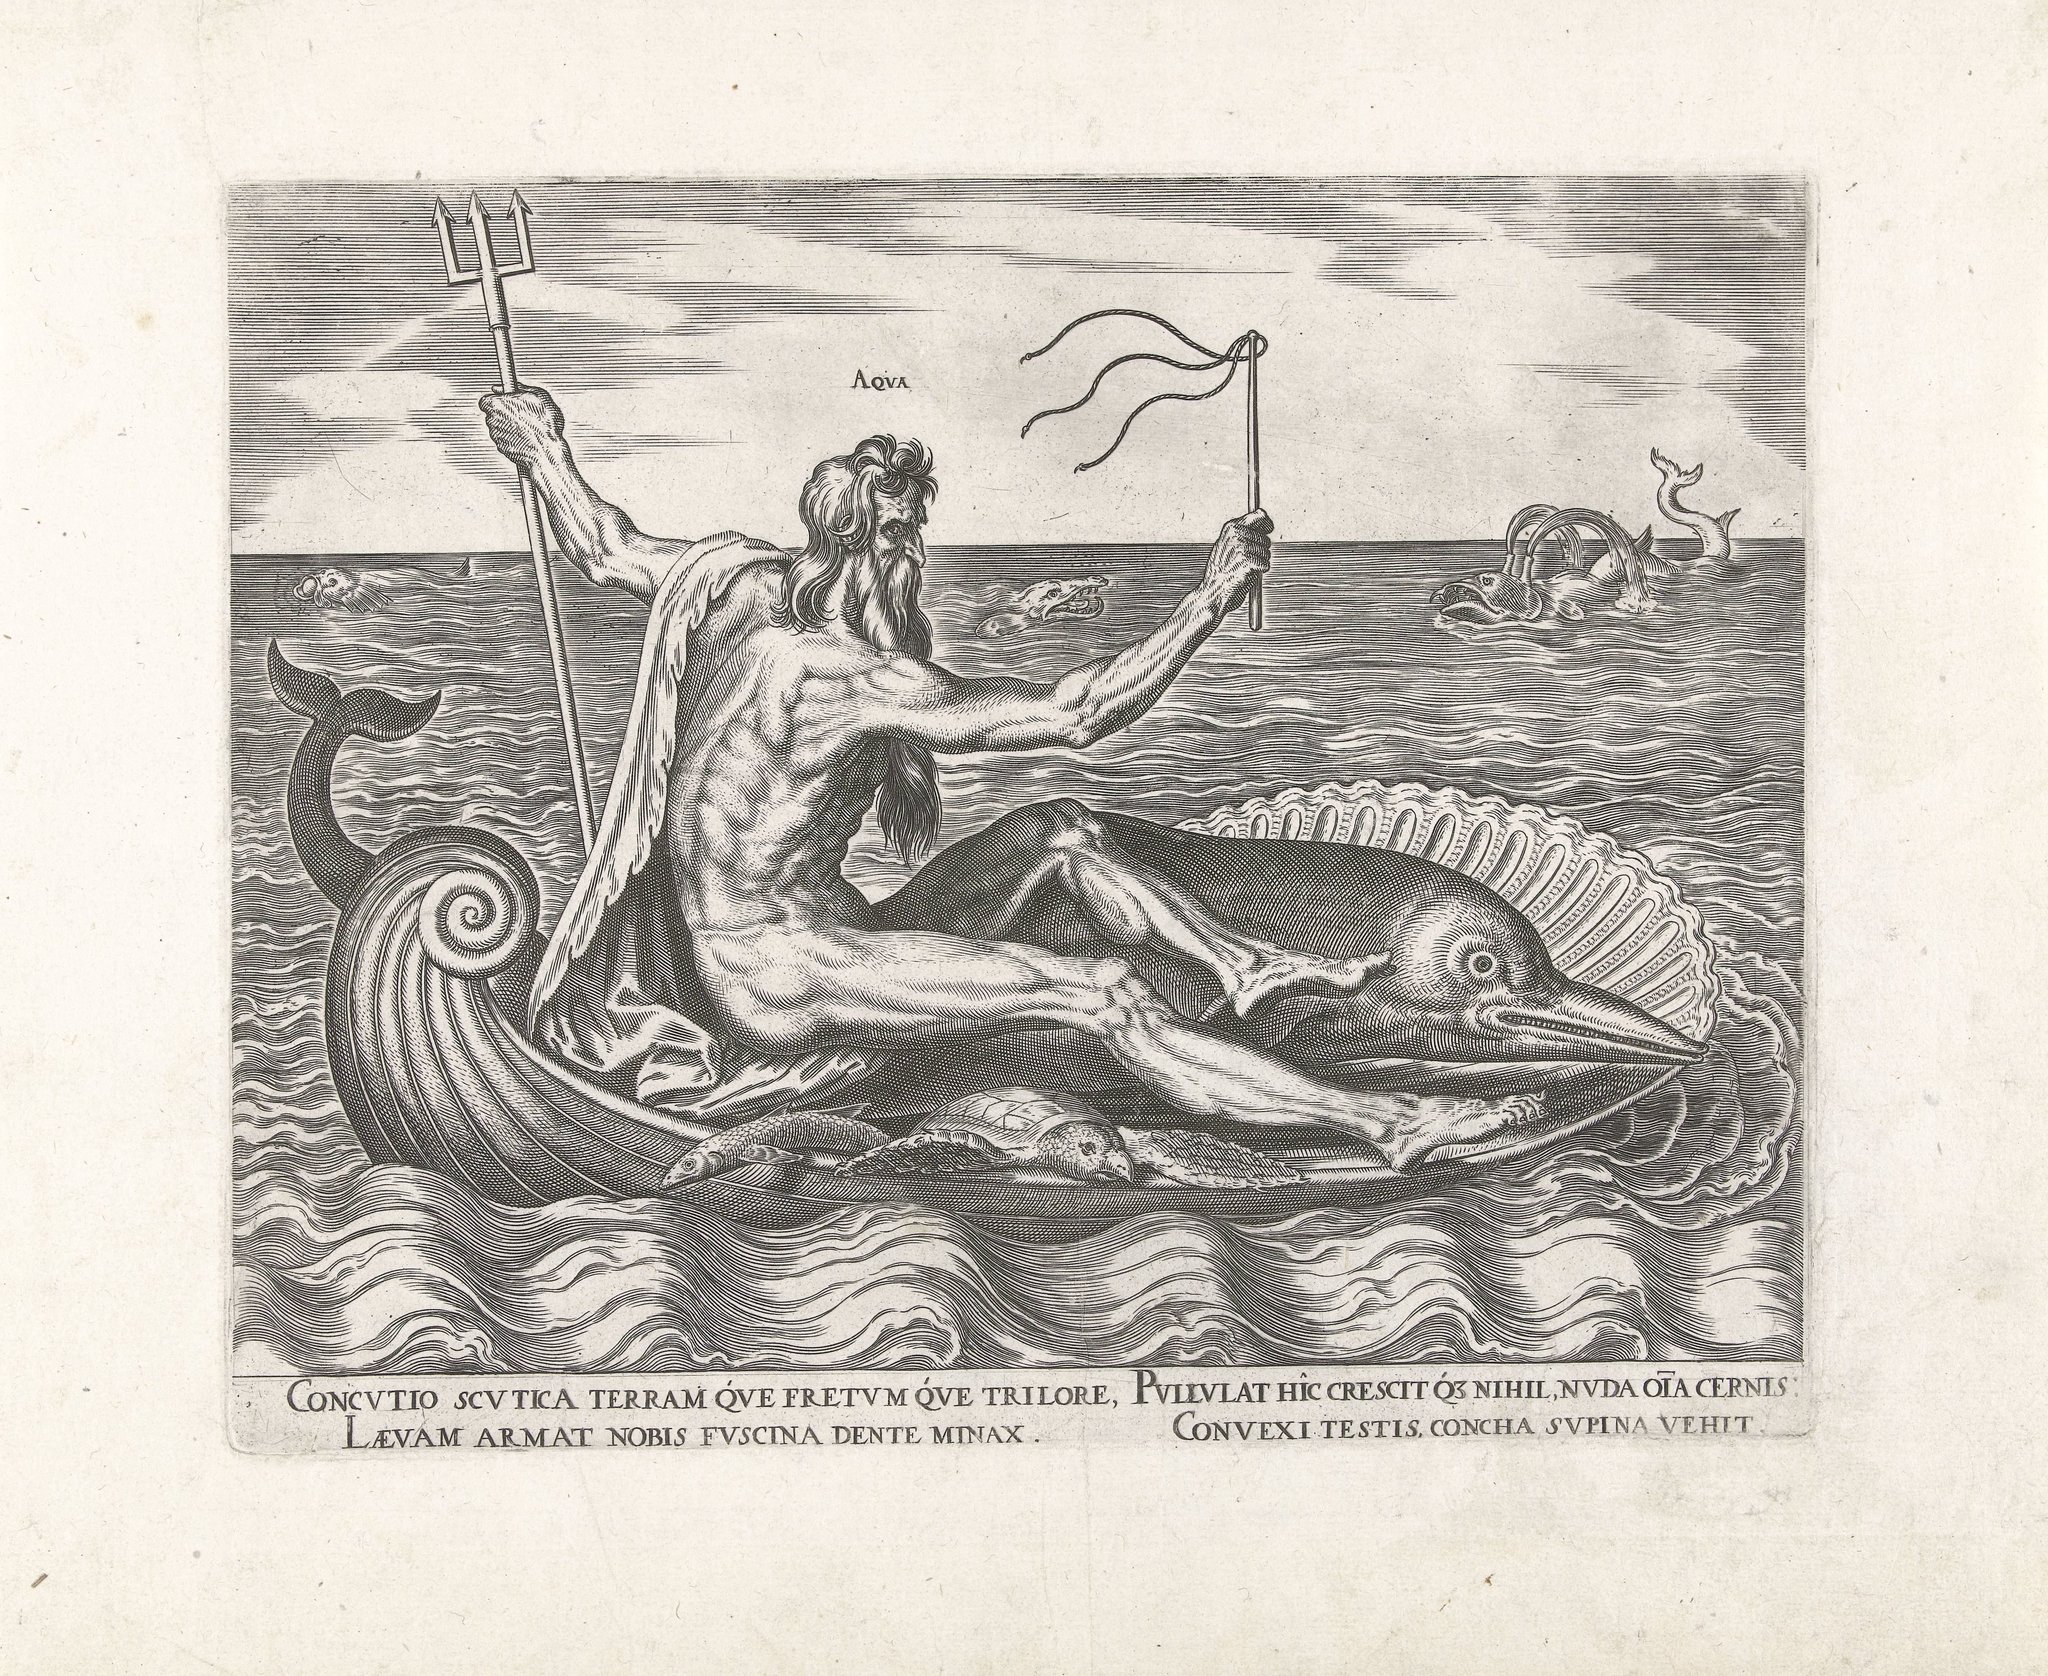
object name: print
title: De vier elementen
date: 1564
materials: paper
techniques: engraving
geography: haarlem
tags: (story of) neptune (poseidon), water (one of the four elements)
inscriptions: collector's mark: Lugt 2228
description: Het element water, gepersonifieerd door Neptunus, rijdend op een schelp. Hij is omringd door water met allerlei vissen en zeewezens. In zijn ene hand een drietand. De prent heeft een Latijns onderschrift. en is deel van een vierdelige serie over de vier elementen.